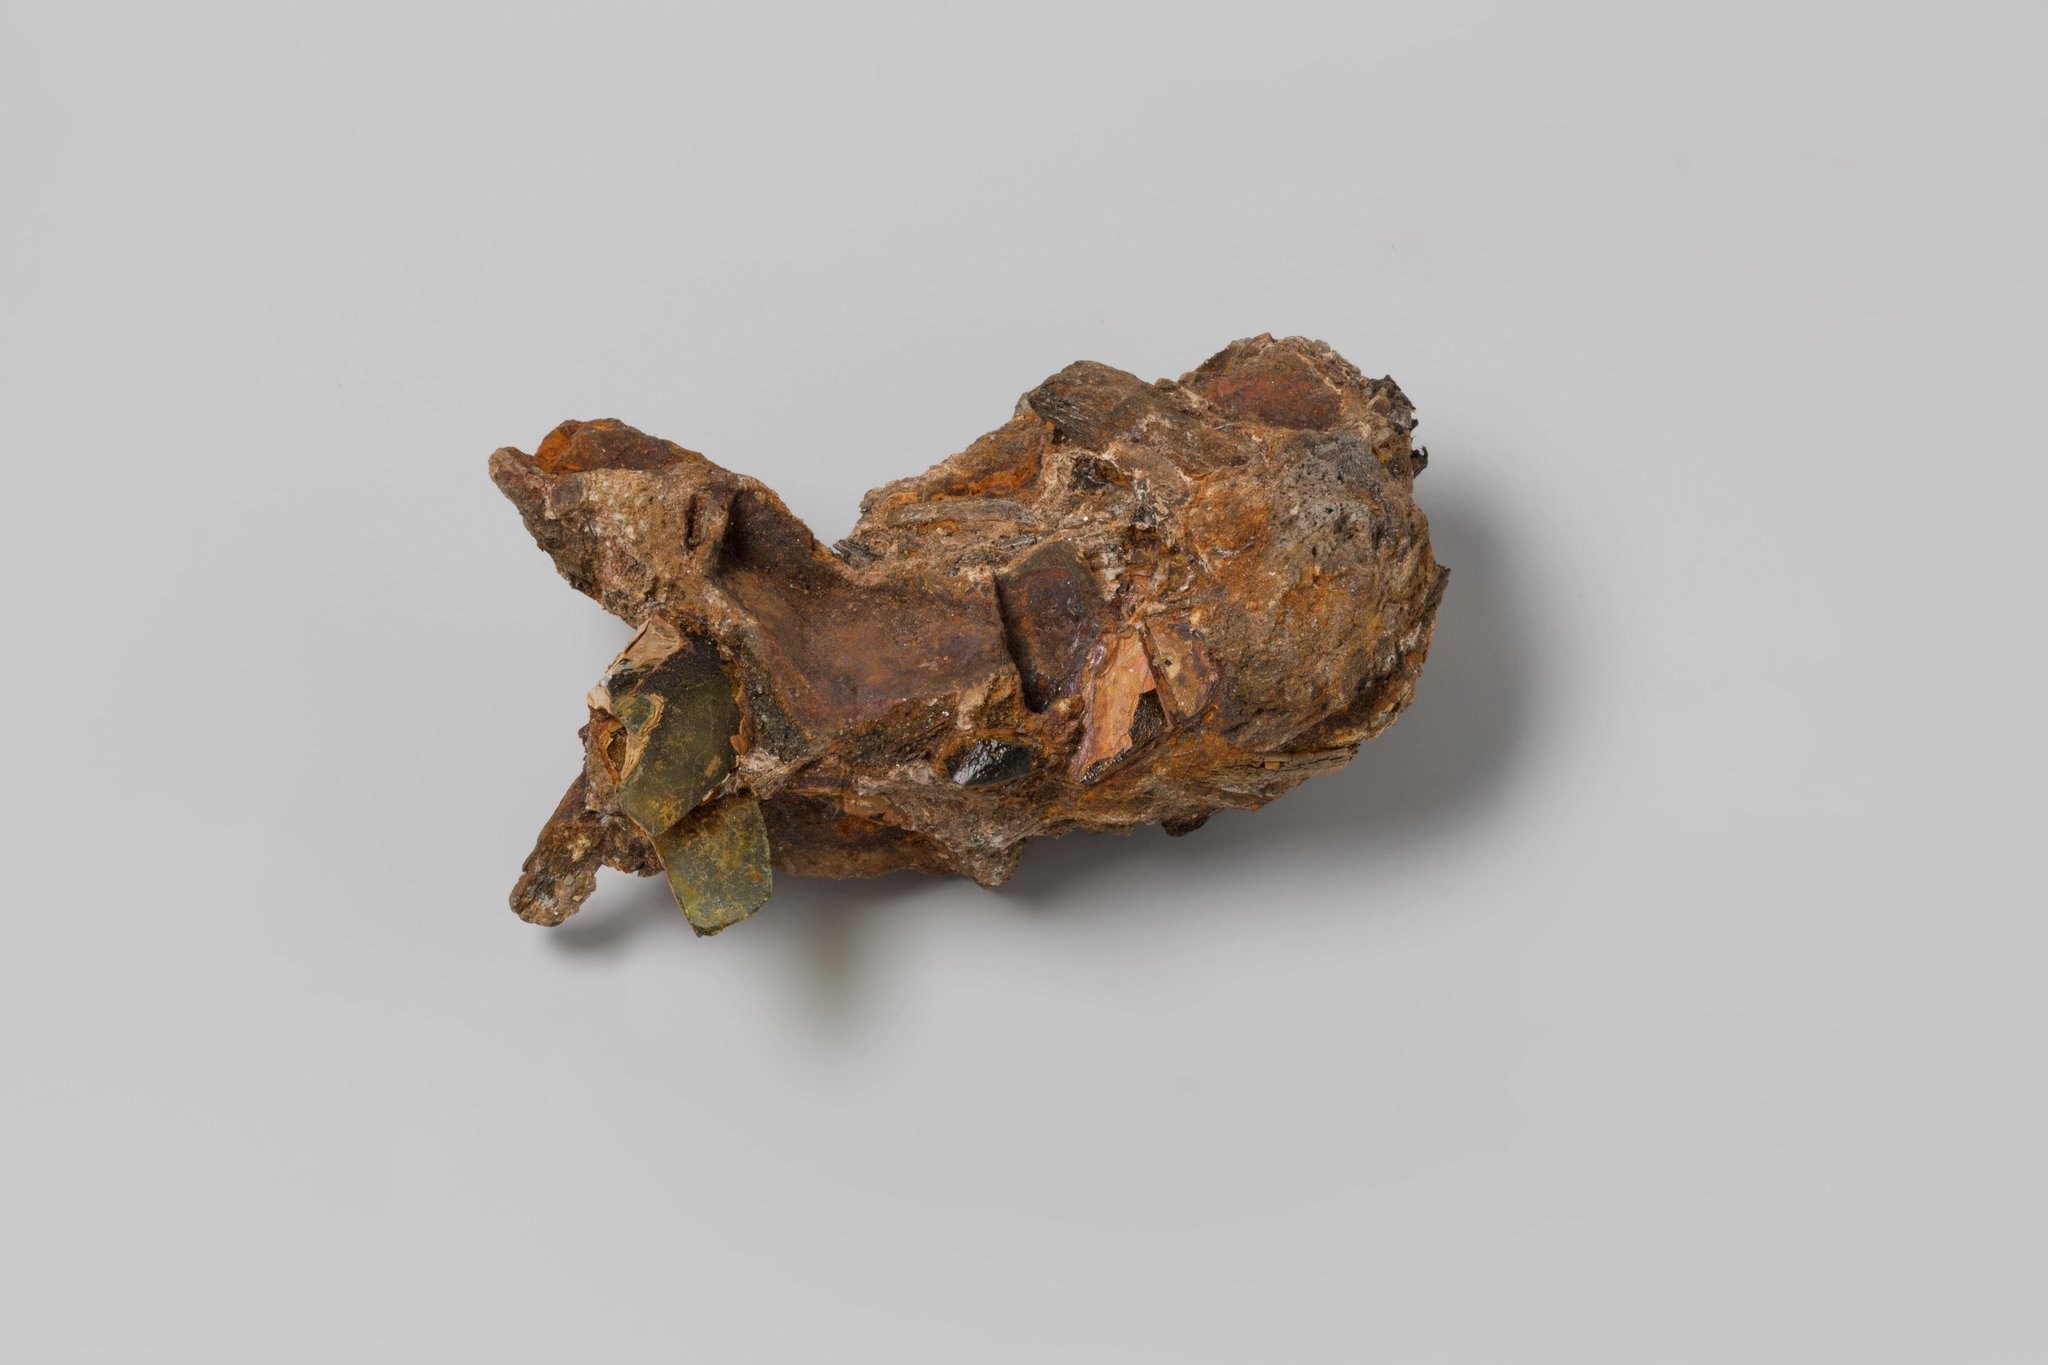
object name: concretionary stone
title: Concretie met glas- en houtfragmenten uit het wrak van de Oost-Indiëvaarder Hollandia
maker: Anonymous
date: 1700-1743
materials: stone, glass, wood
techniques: green glass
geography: netherlands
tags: verenigde oostindische compagnie, hollandia (schip), annet